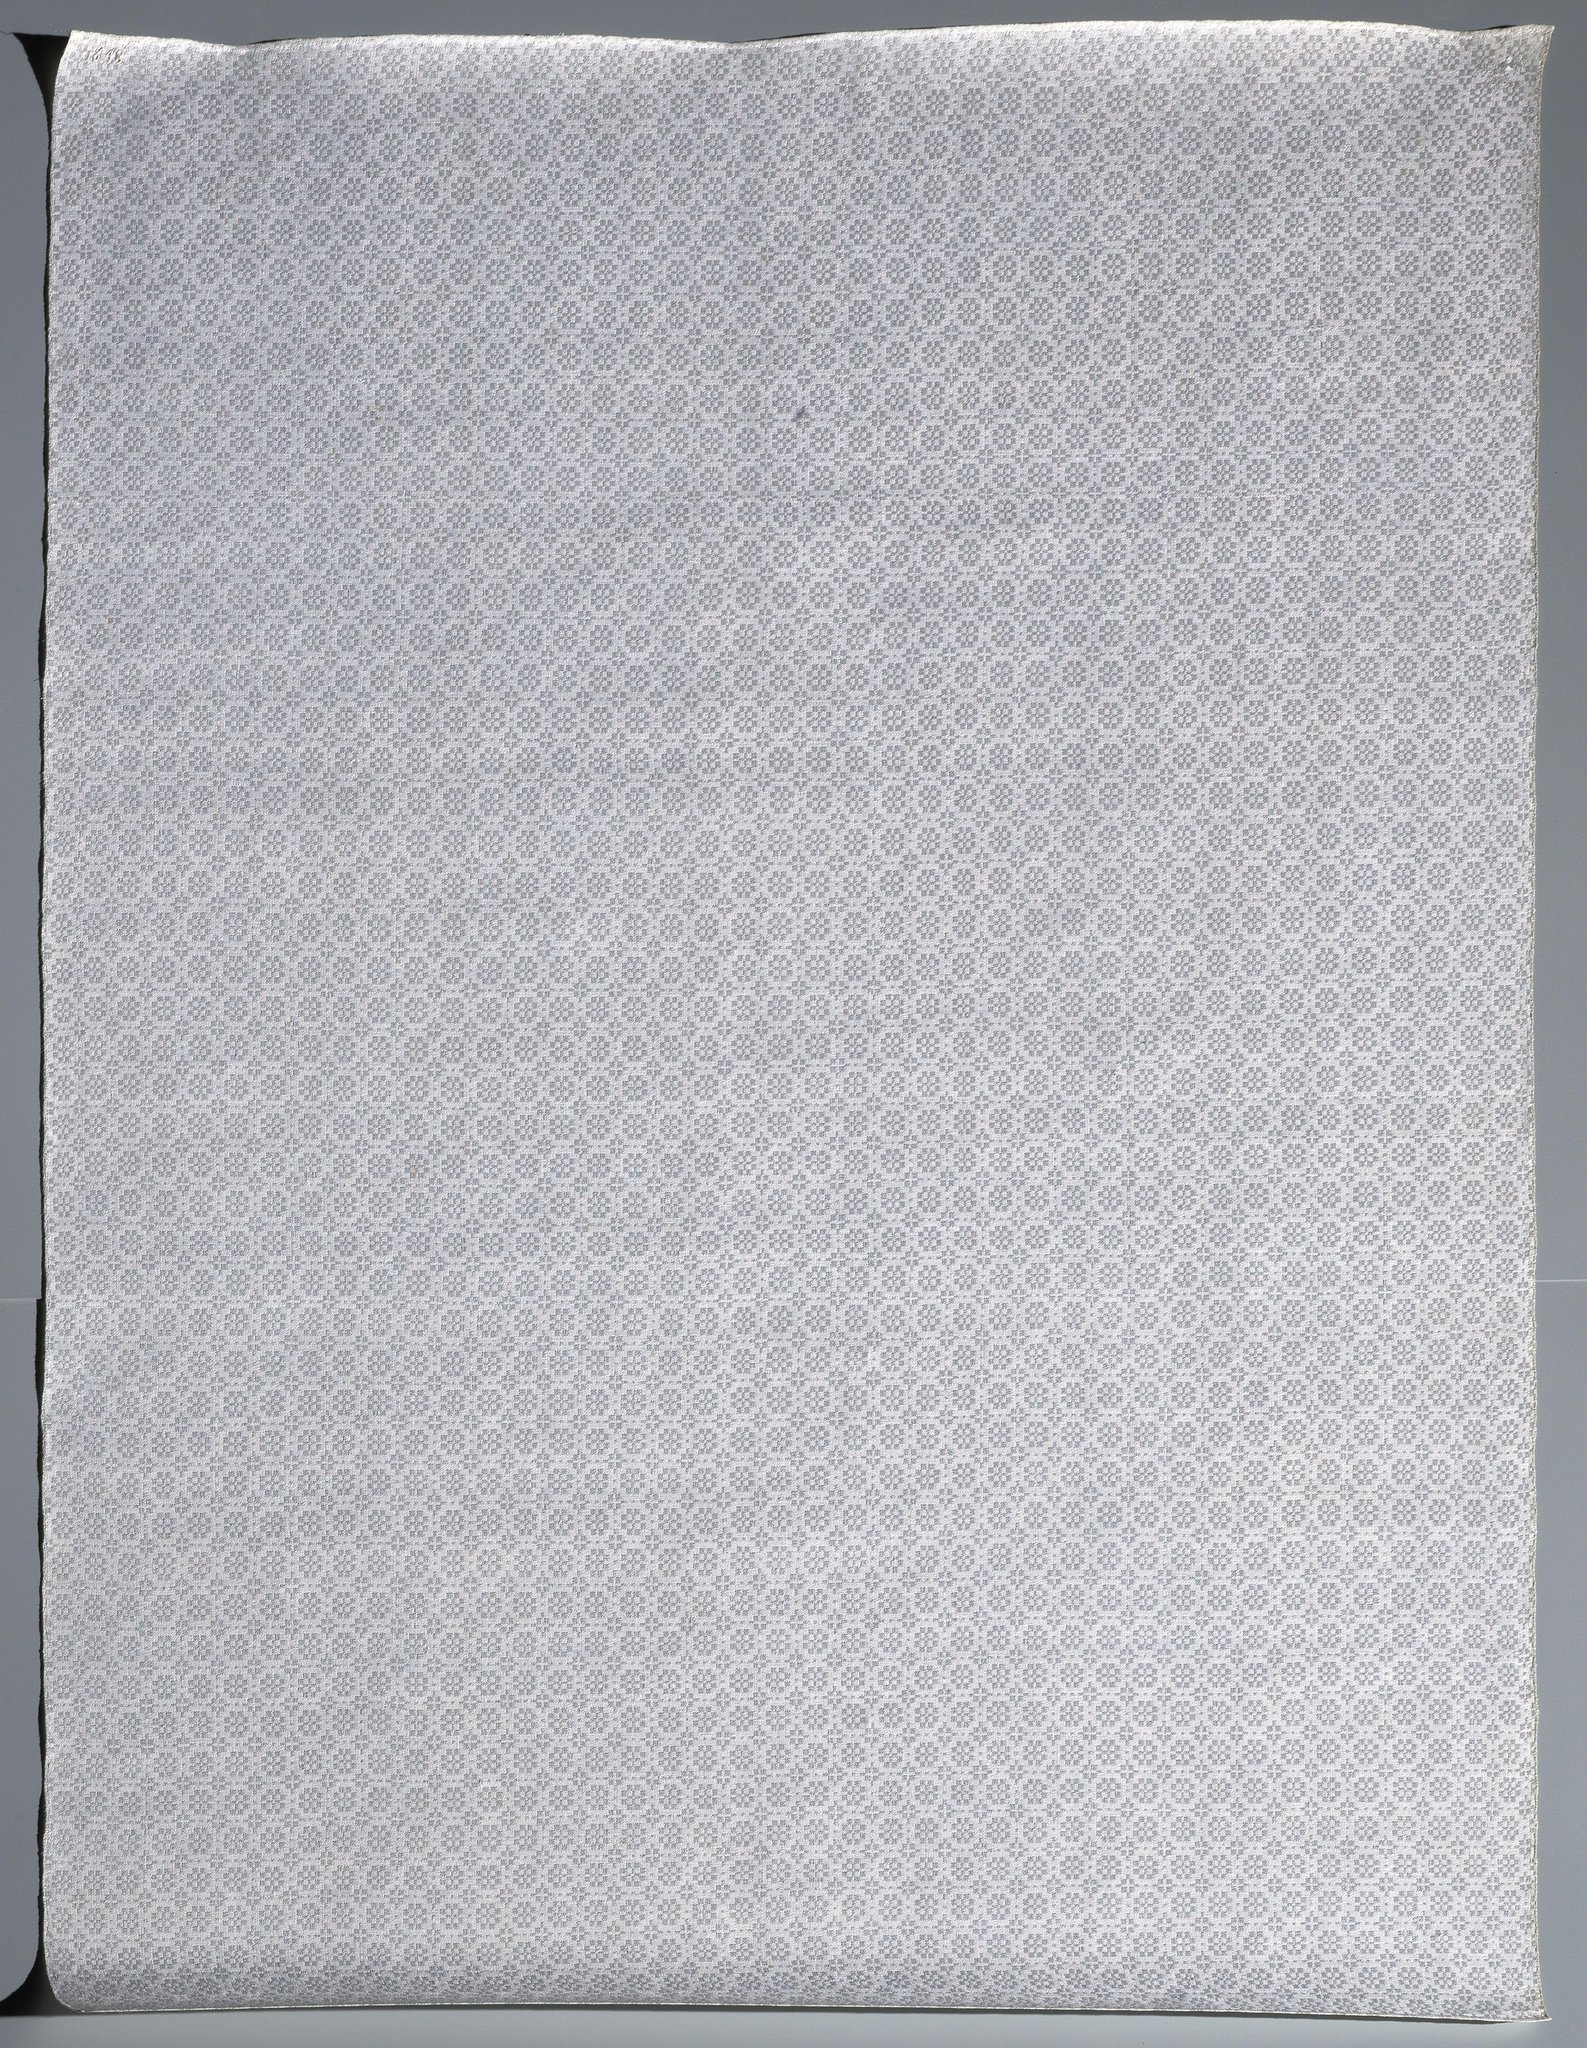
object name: napkin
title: Servet met pellenpatroon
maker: Anonymous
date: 1648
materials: linen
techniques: peeled fabric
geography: netherlands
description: wit linnen servet met een pellen patroon (kruisje) en z.g. kattepoot, merk AVS 1648 en kroon WG WH 2oonl